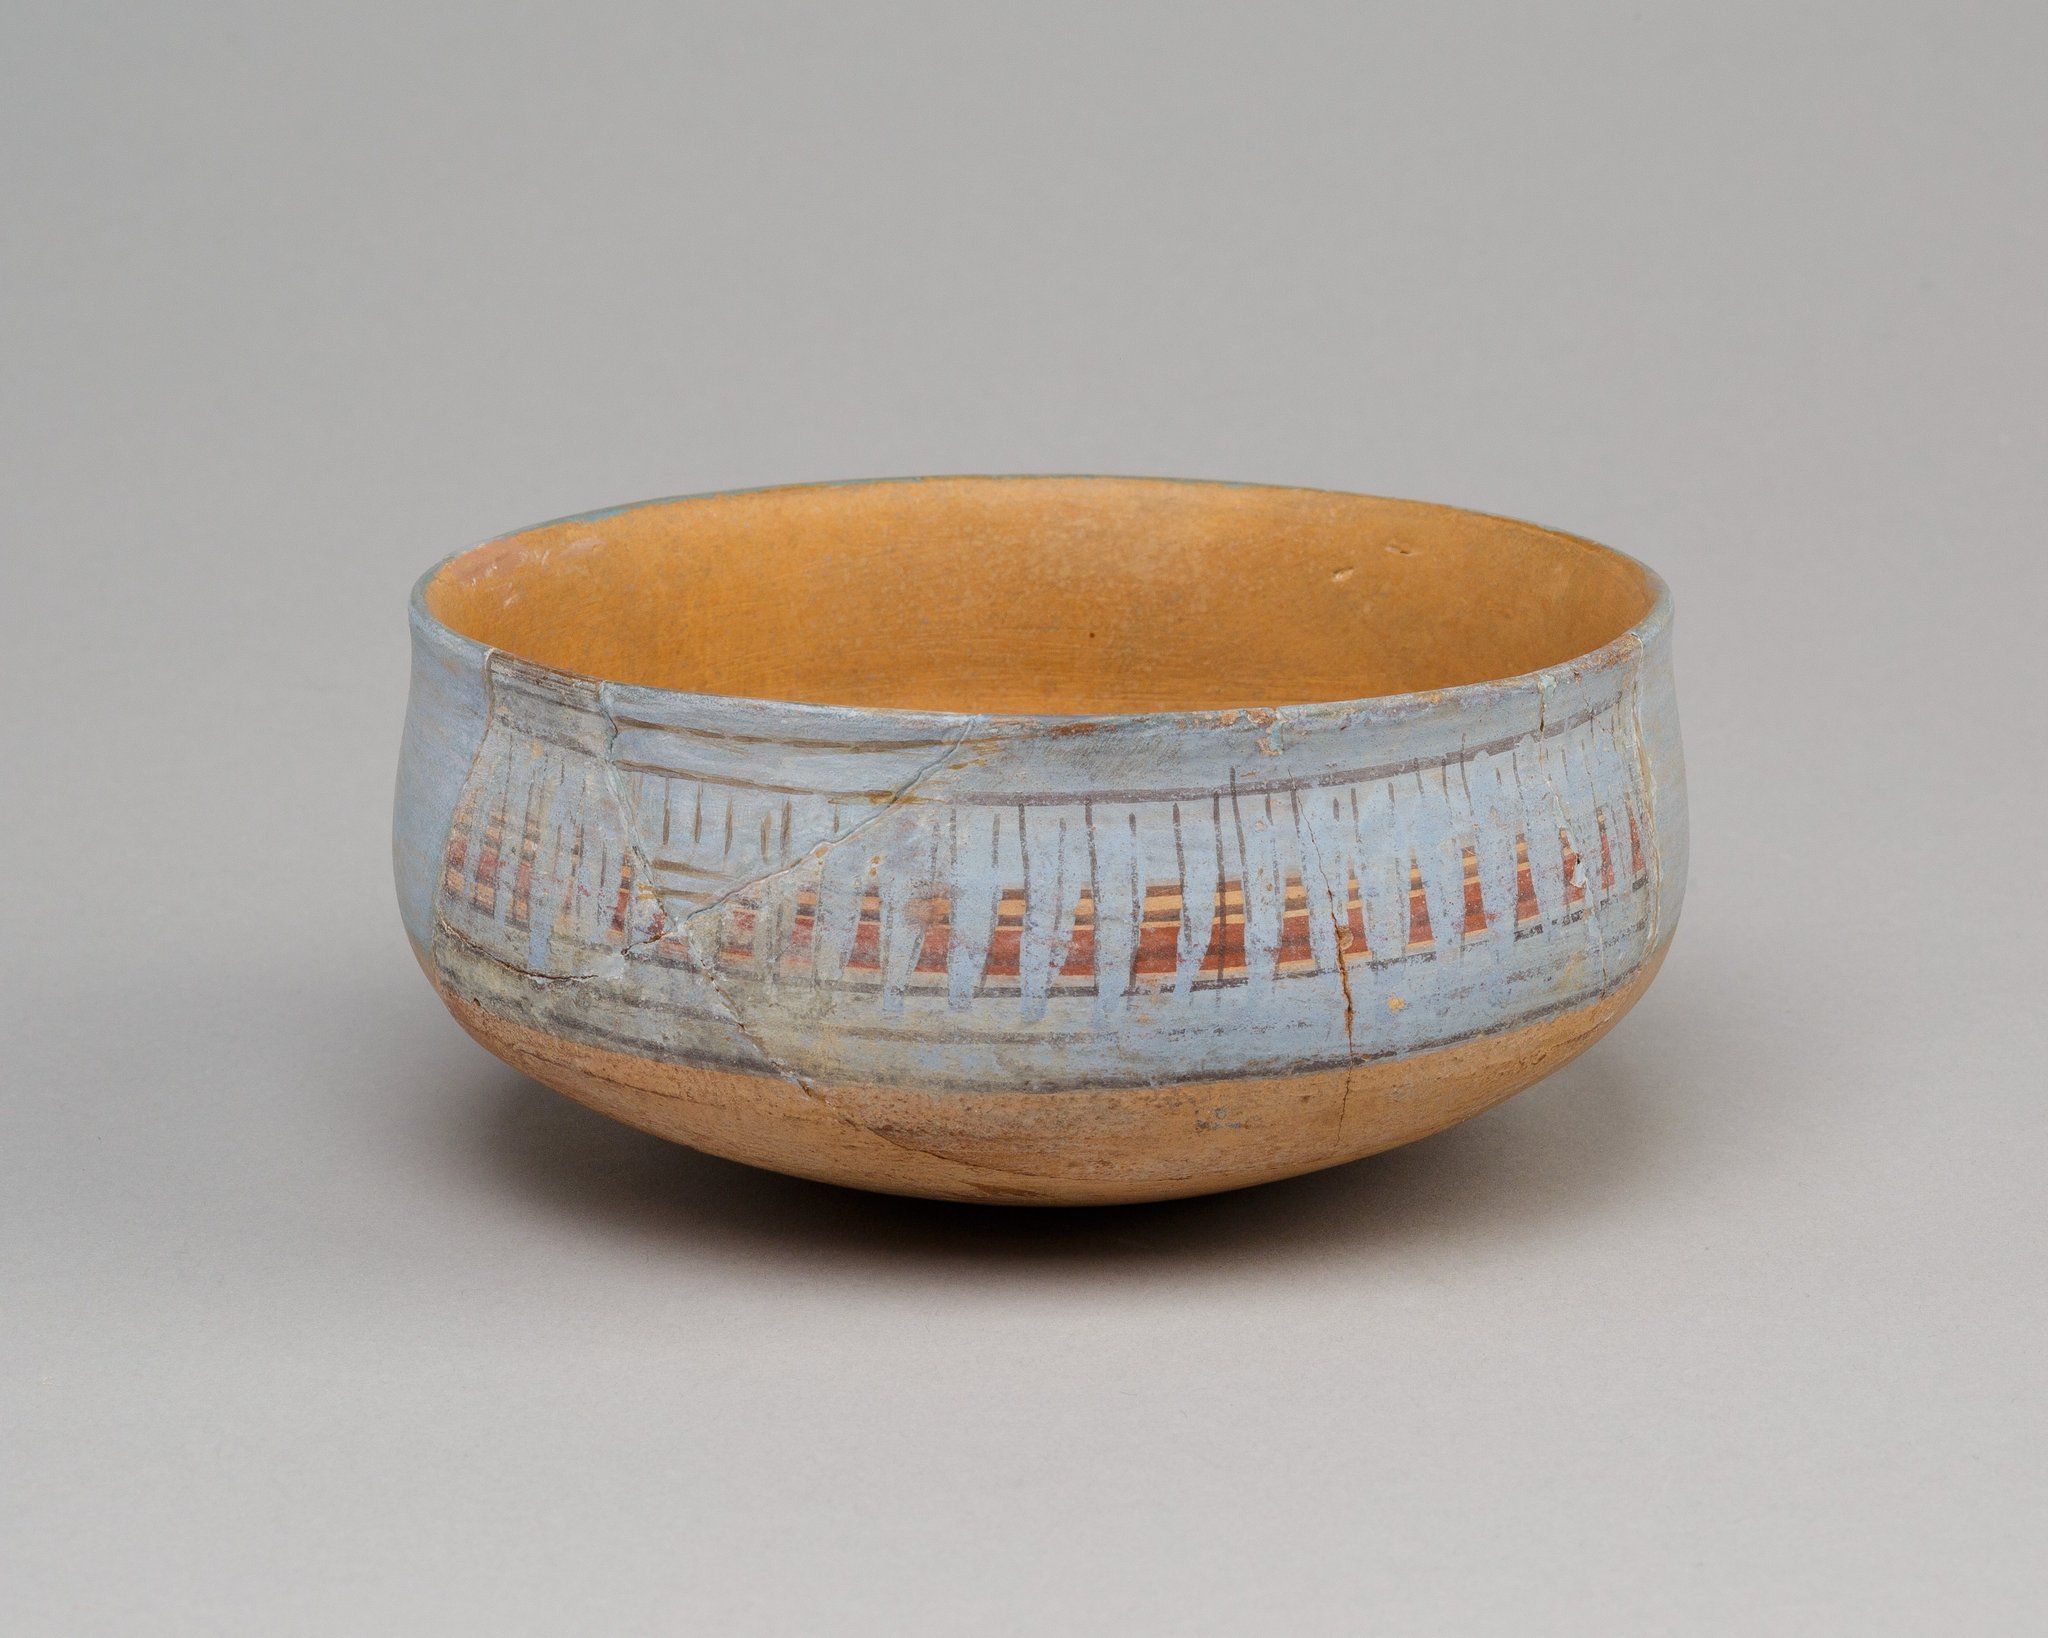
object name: bowl, painted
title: Painted Bowl from Tutankhamun's Embalming Cache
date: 1336-1327 BCE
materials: pigment, pottery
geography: egypt